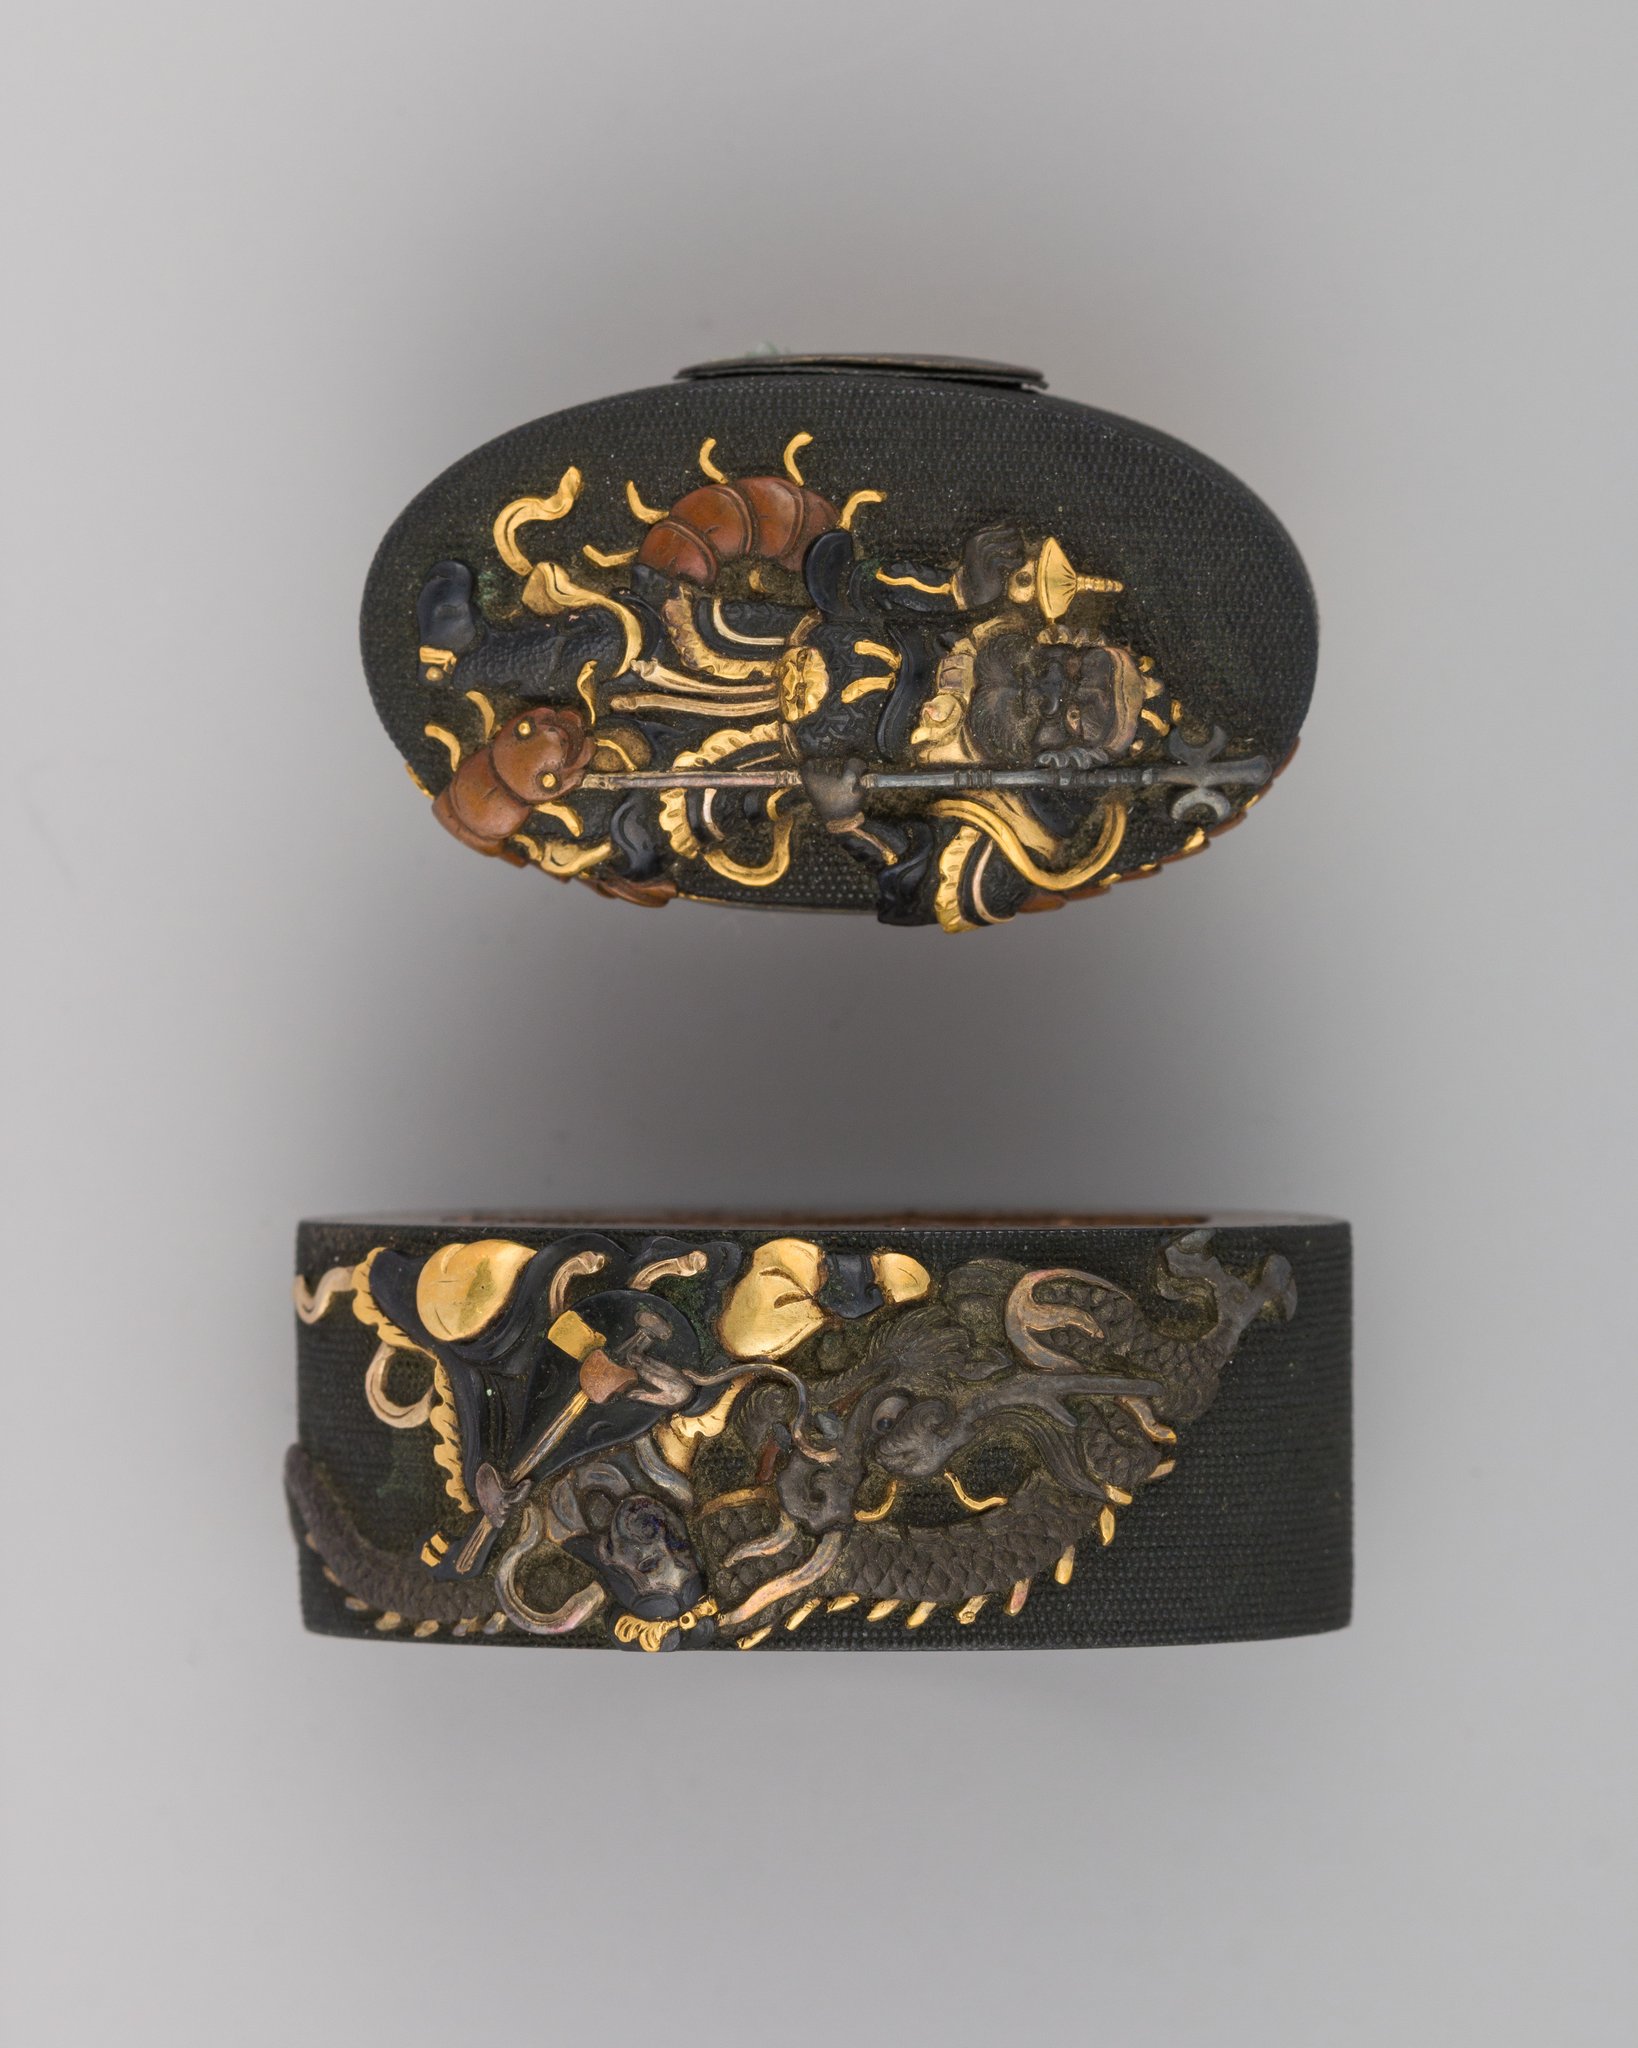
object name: sword hilt collar and pommel fuchigashira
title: Sword-Hilt Collar and Pommel (Fuchigashira)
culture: japanese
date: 1801-1900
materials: copper, gold alloy, silver alloy, gold, silver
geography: japan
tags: dragons,insects